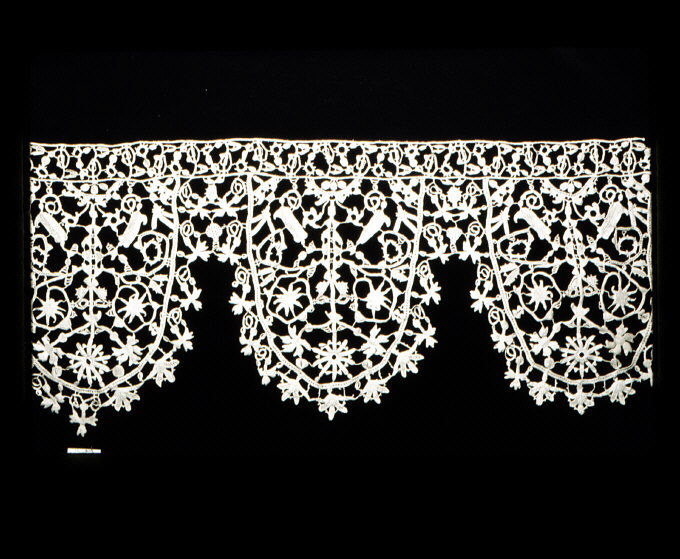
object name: edging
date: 1601-1633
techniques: lace